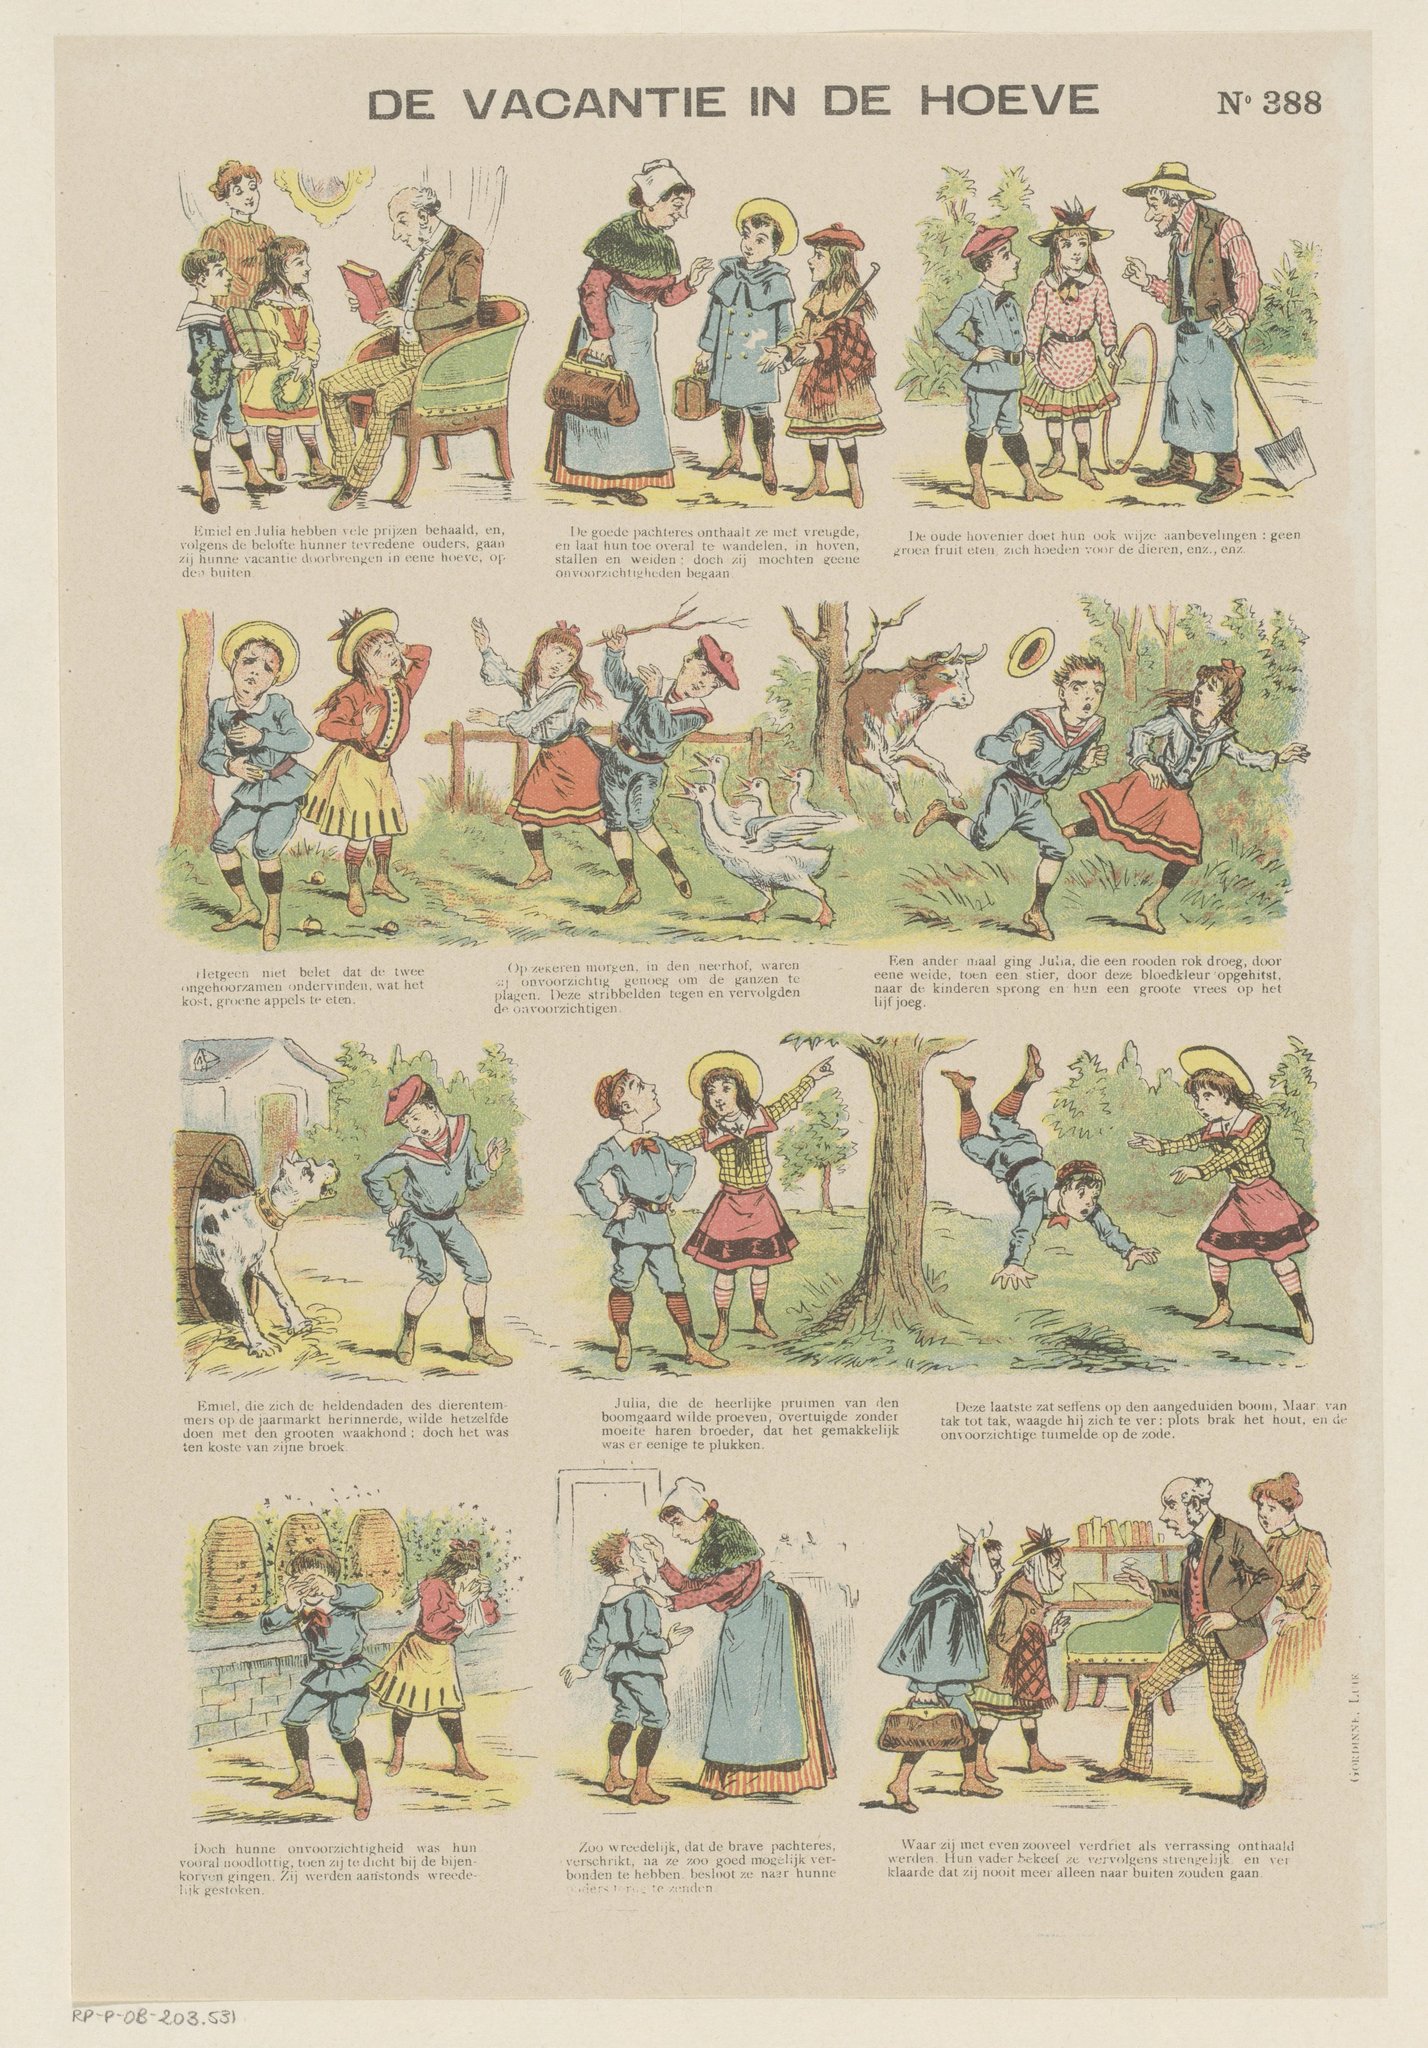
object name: print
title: De vacantie in de hoeve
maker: Anonymous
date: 1894-1959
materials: paper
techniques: lithograph, letterpress printing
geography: liège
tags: mischief-making play, magic, supernaturalism, occultism, woodcutting, woodcutter ~ forestry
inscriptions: collector's mark: Lugt 2760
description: Blad met 12 voorstellingen over broer en zus Emiel en Julia die op vakantie naar een hoeve gaan. Daar halen ze zoveel kattenkwaad uit dat de pachteres ze weer naar huis stuurt. Onder elke afbeelding een onderschrift. Genummerd rechtsboven: No 388.